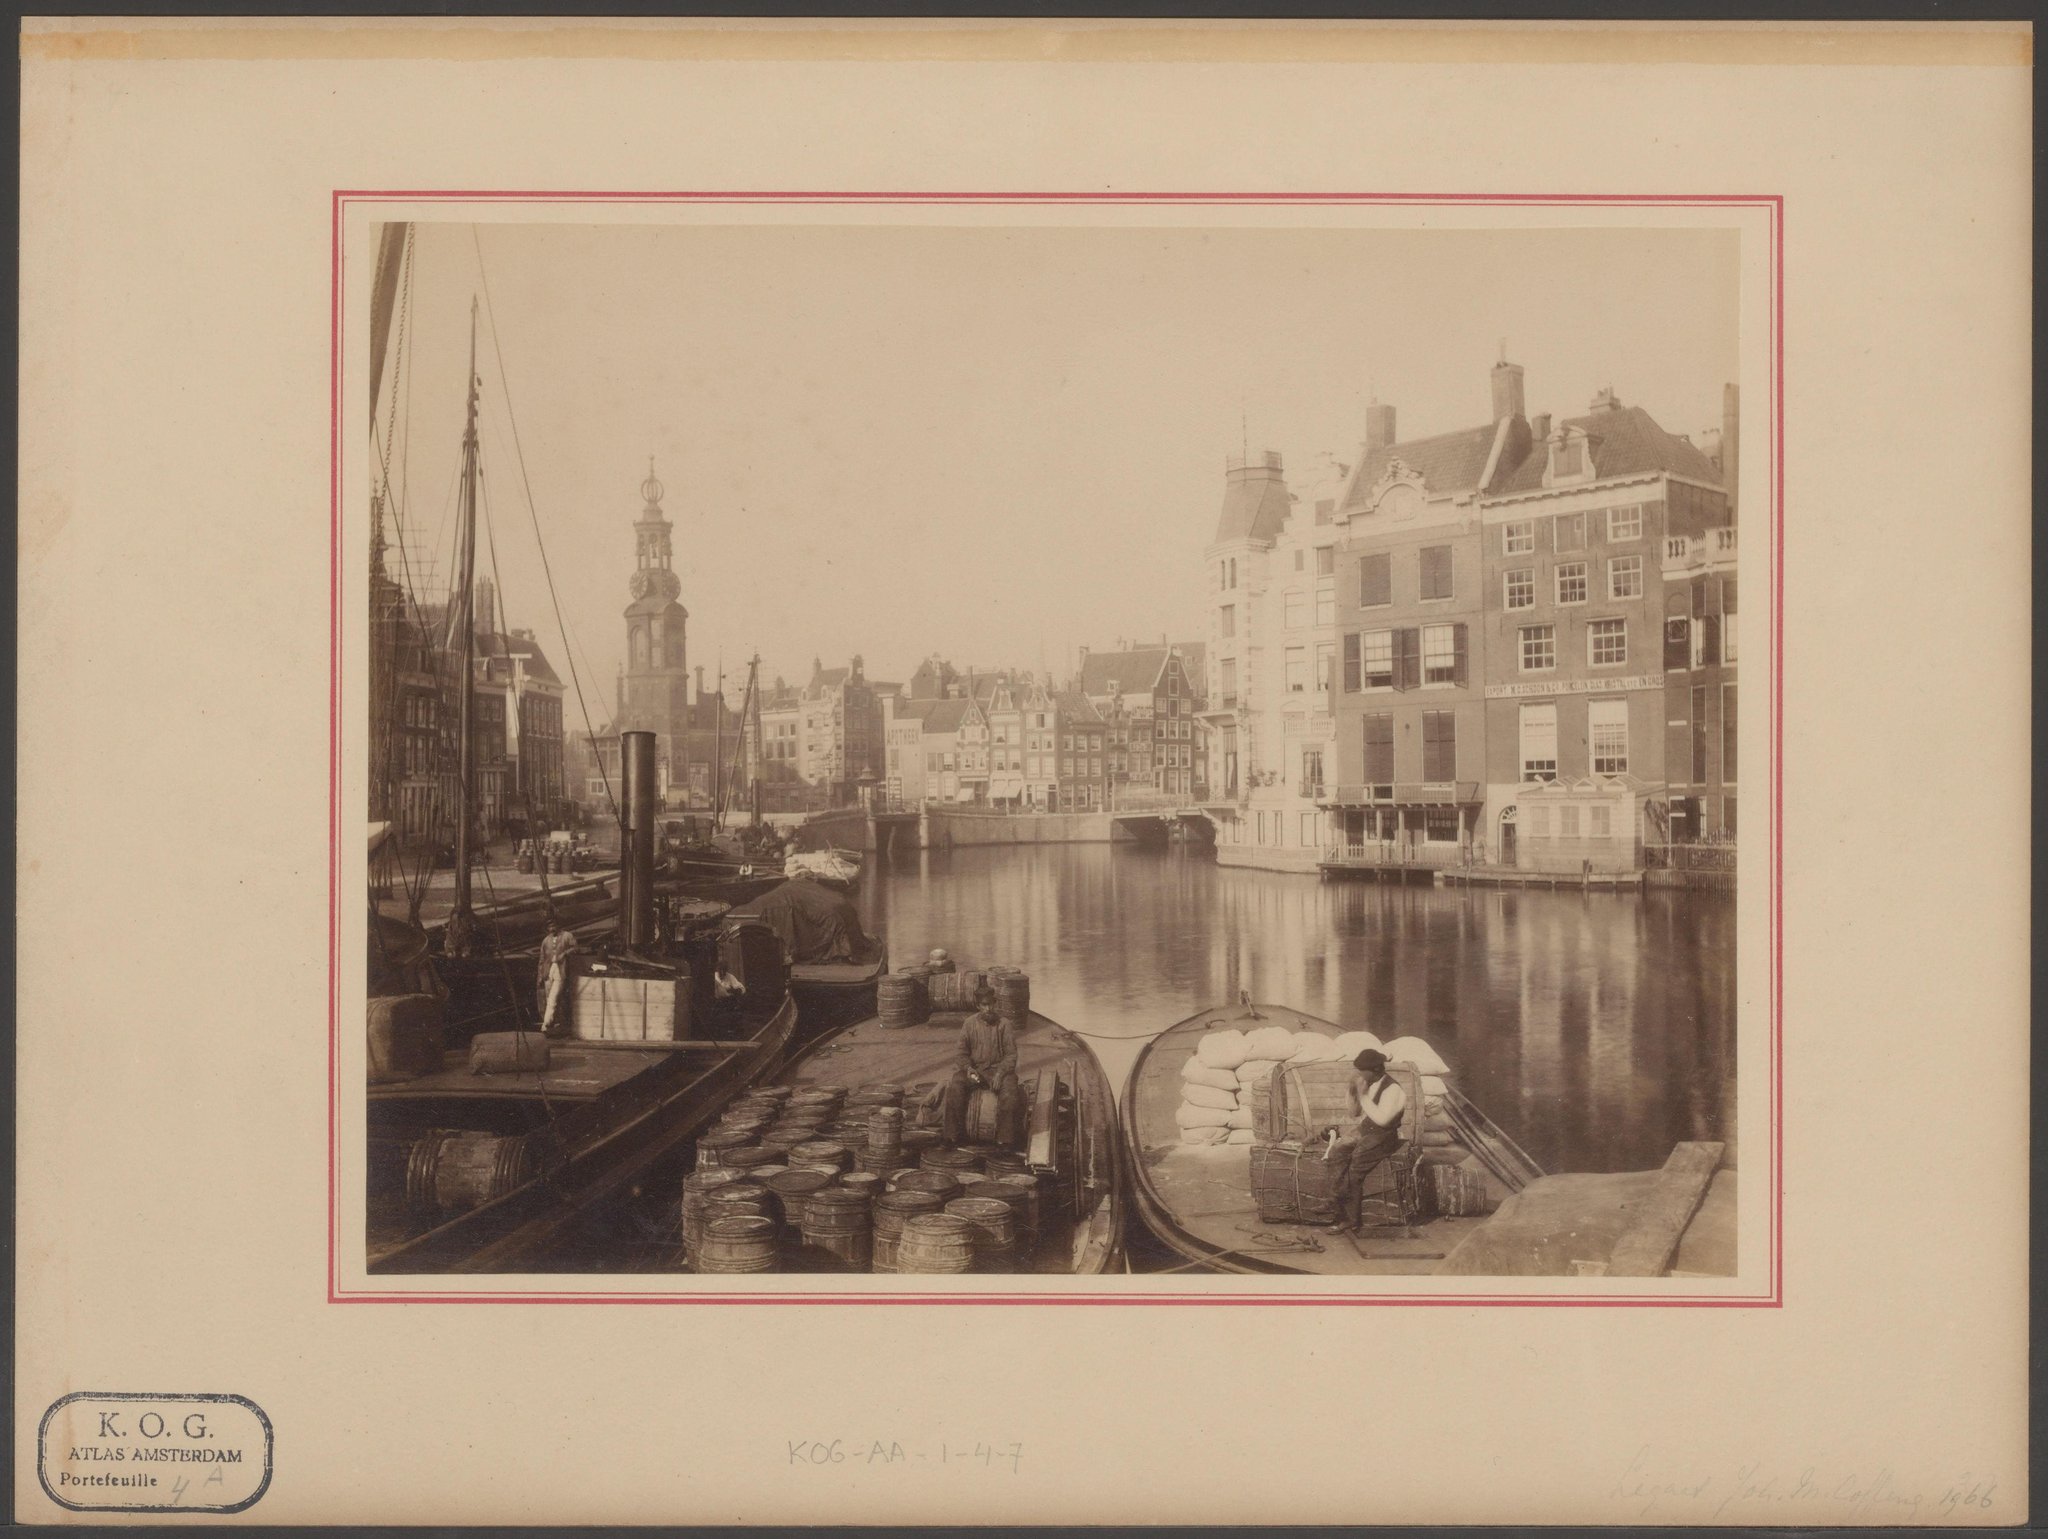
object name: photograph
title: Gezicht op de Binnen-Amstel en het Muntplein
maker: Anonymous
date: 1850-1925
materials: cardboard, paper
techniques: albumen print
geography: amsterdam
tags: tower, clock tower ~ monumental adornment, city-view in general; 'veduta', canal, bridge in city across river, canal, etc.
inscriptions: collector's mark: ‘4A’ Lugt 1641b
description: Onderwerpsrubriek binnen de Atlas Amsterdam: Amstel van Doelensluis tot Blauwbrug.